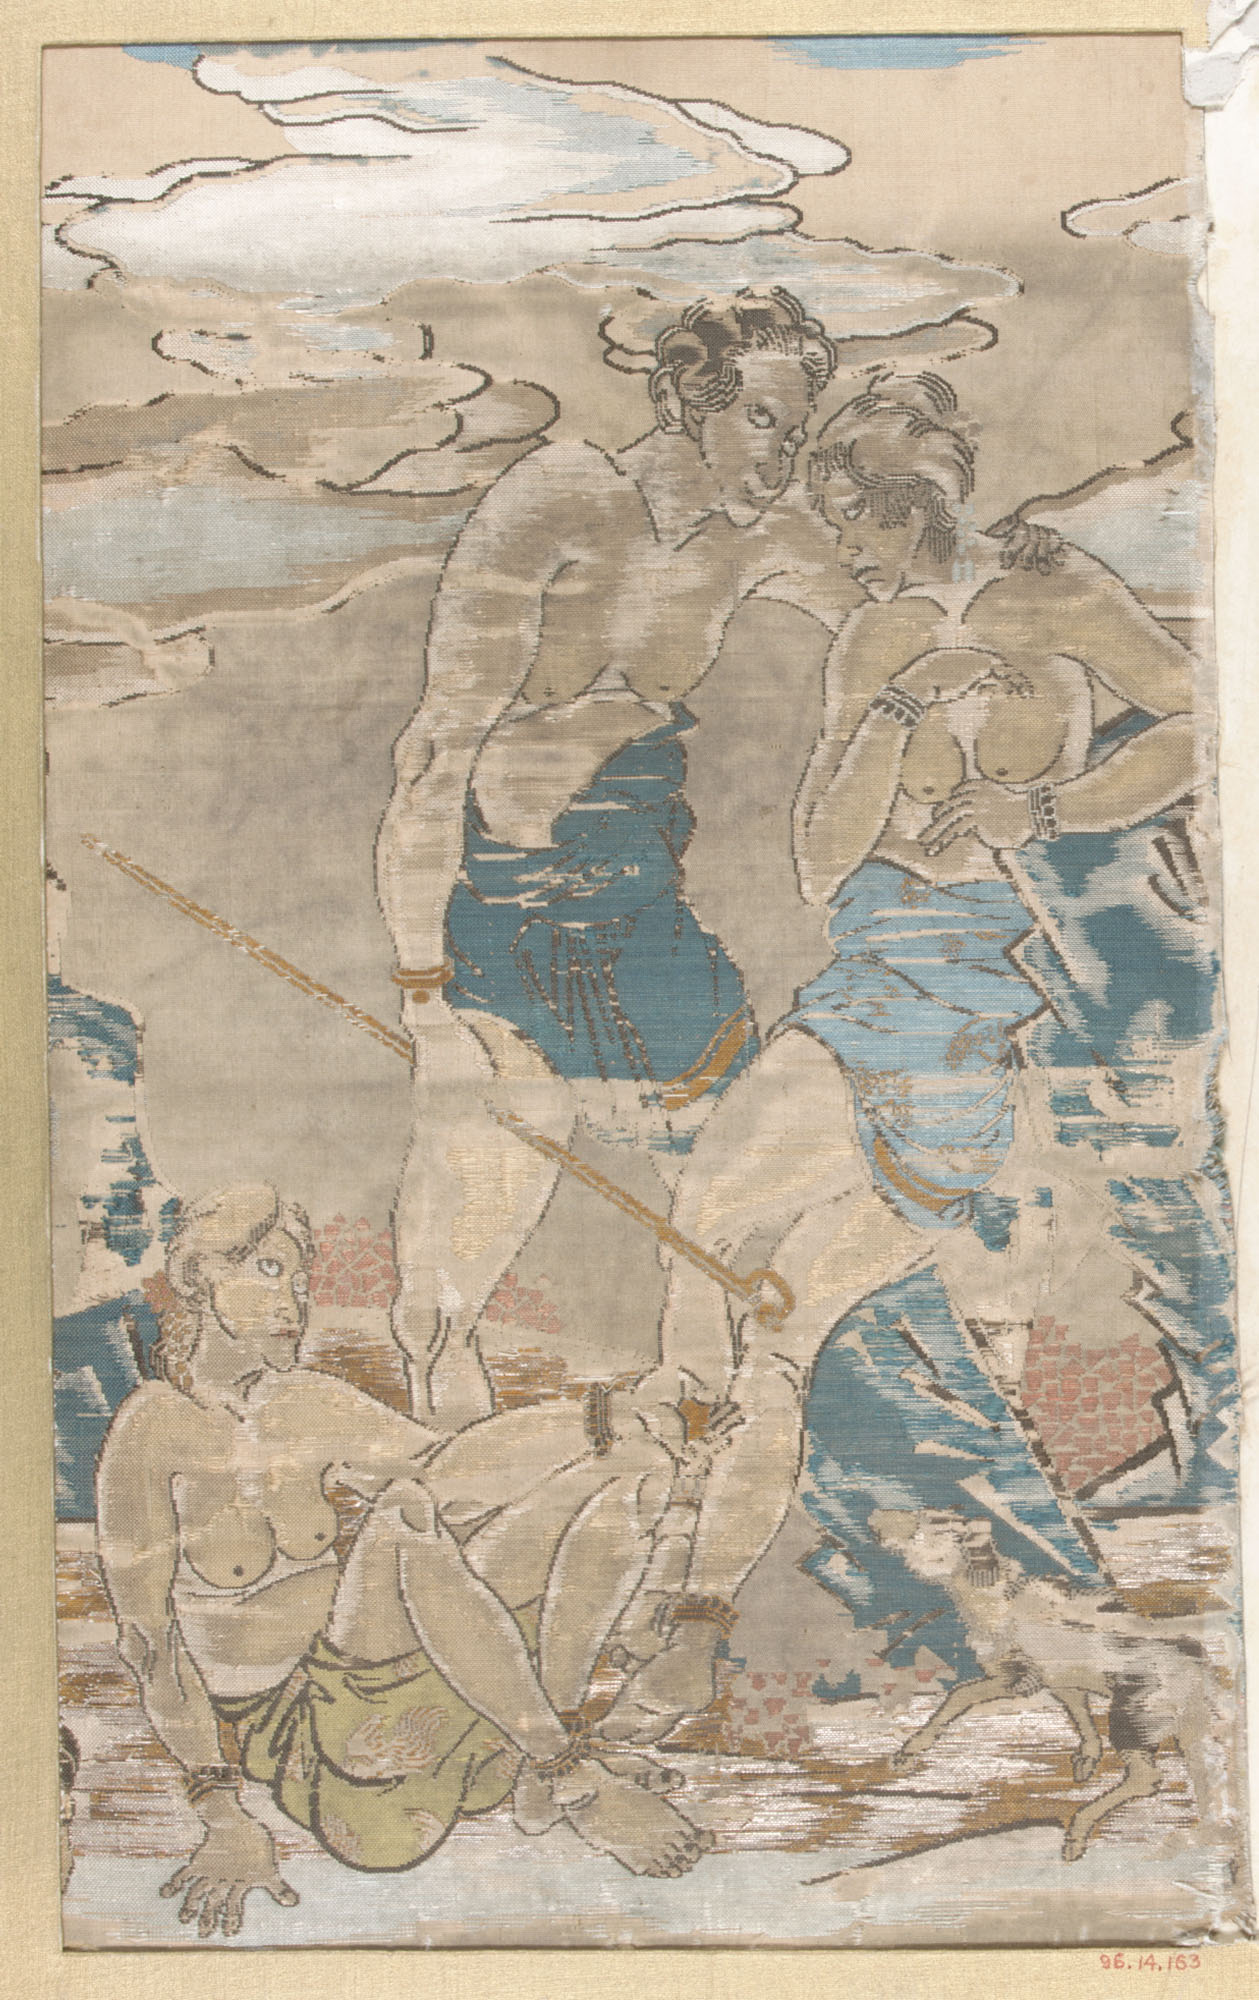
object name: piece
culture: japanese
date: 1701-1900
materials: silk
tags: animals,men